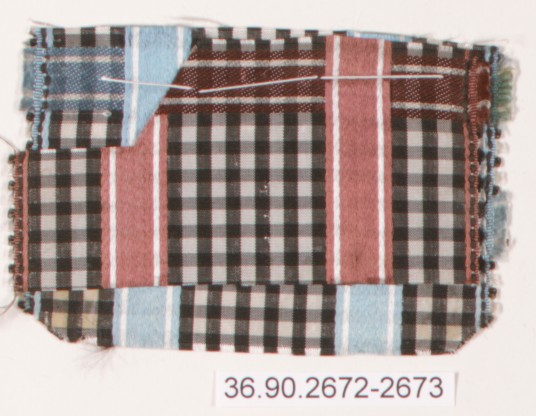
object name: ribbon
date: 1801-1900